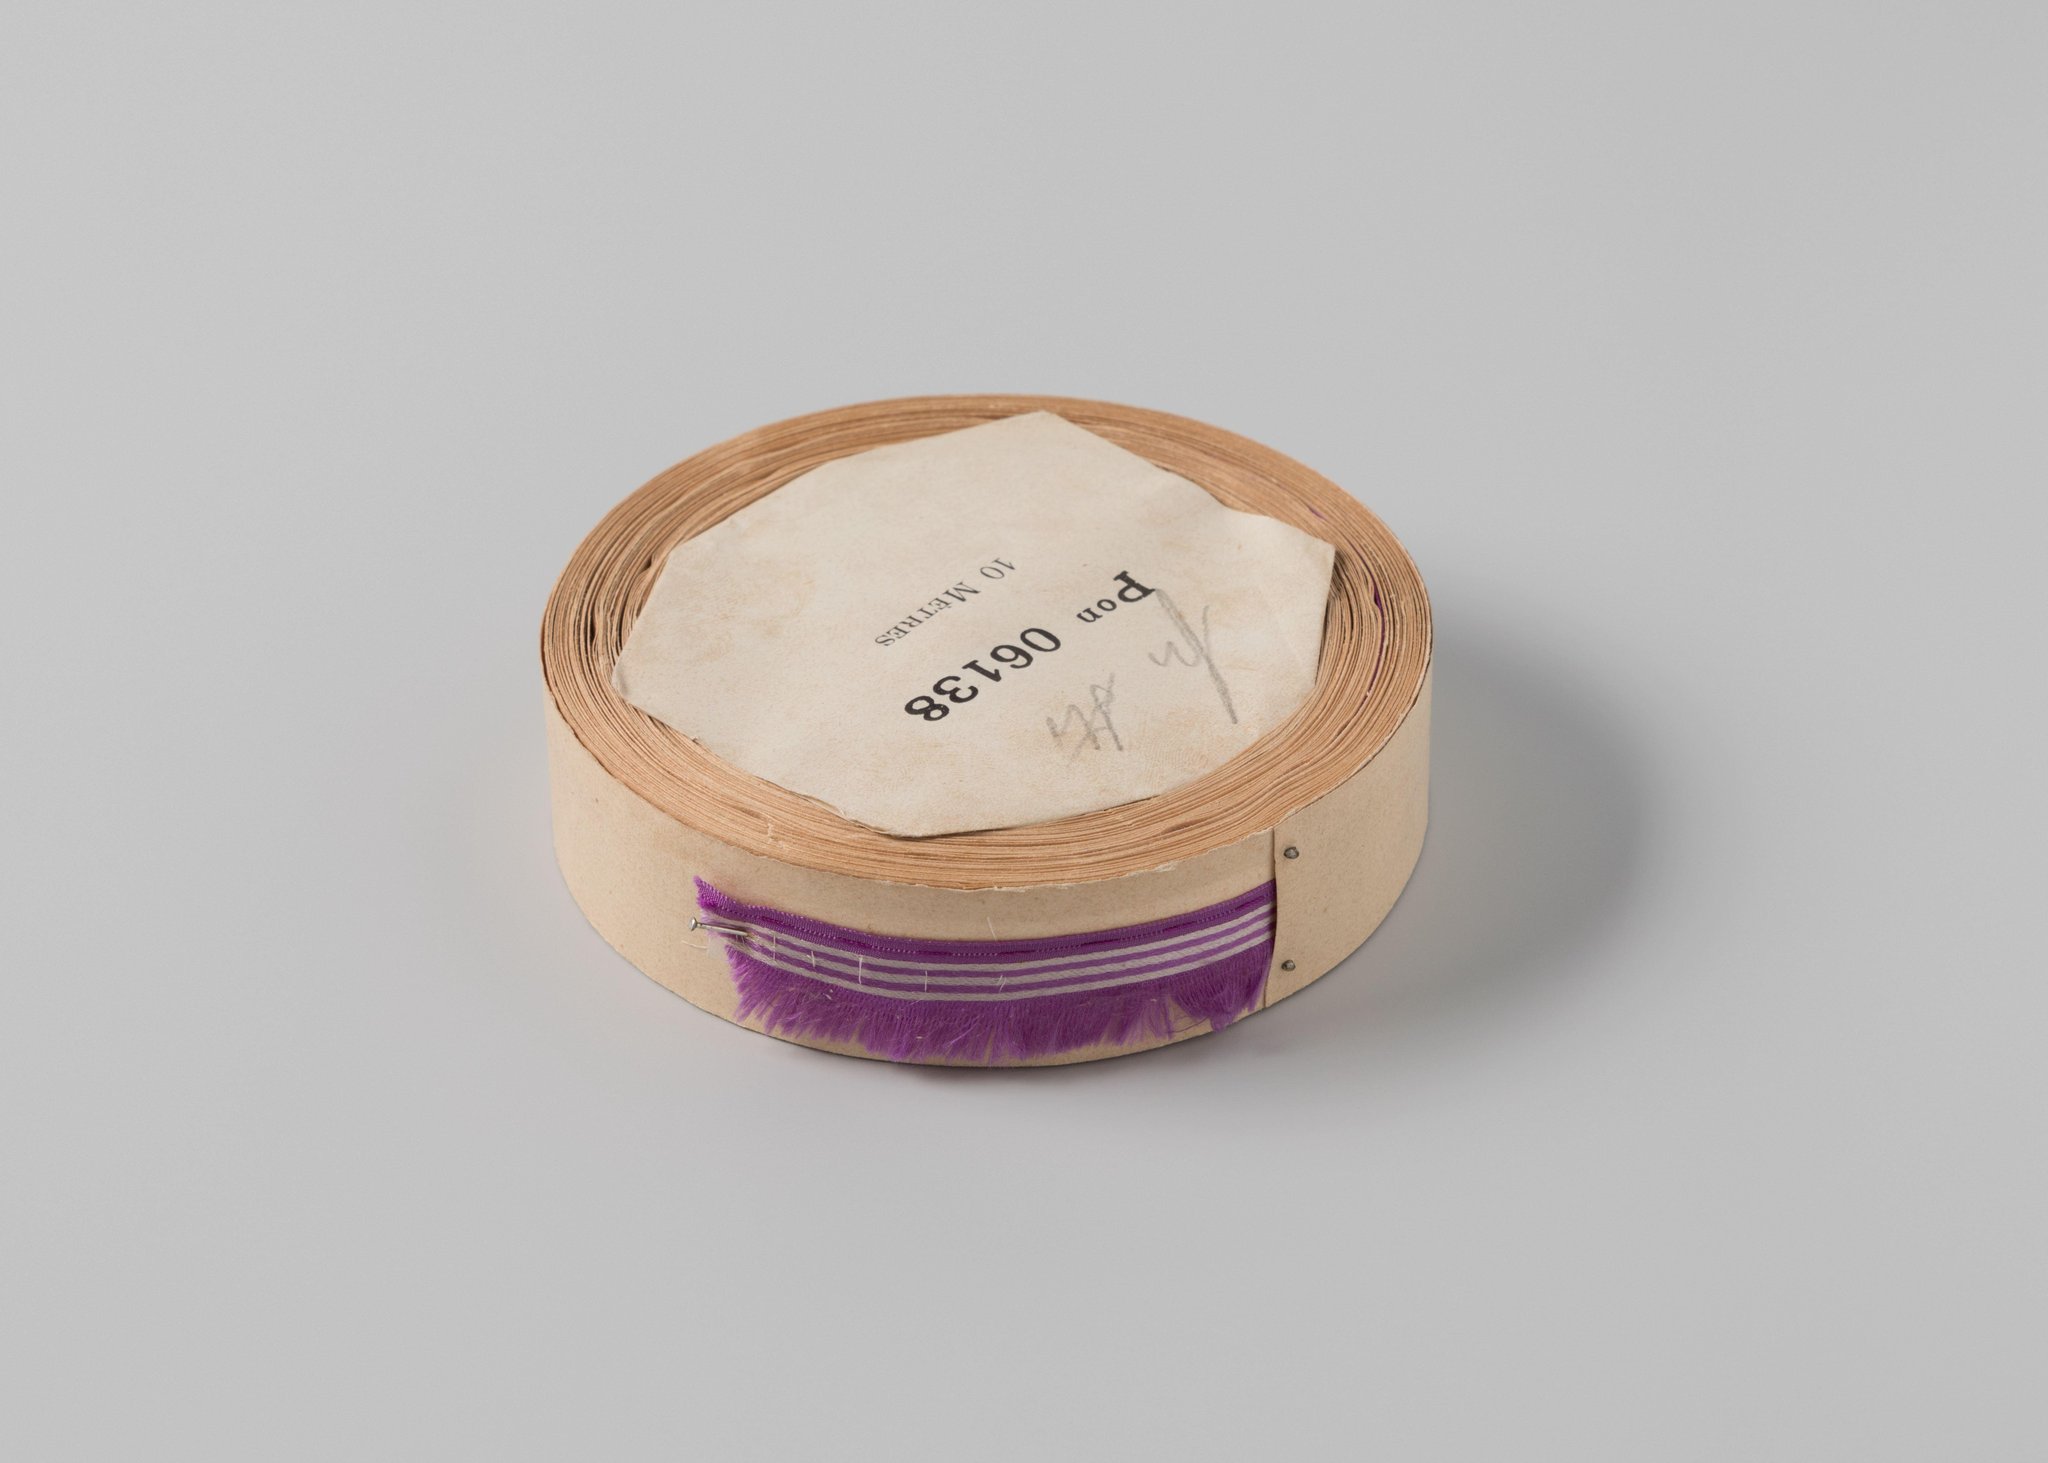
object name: braid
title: Rol met paars lint met één gerafelde zijde en drie witte horizontale strepen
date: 1935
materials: cardboard, paper, textile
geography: nijmegen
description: Rol met paars lint met één gerafelde zijde en drie witte horizontale strepen.